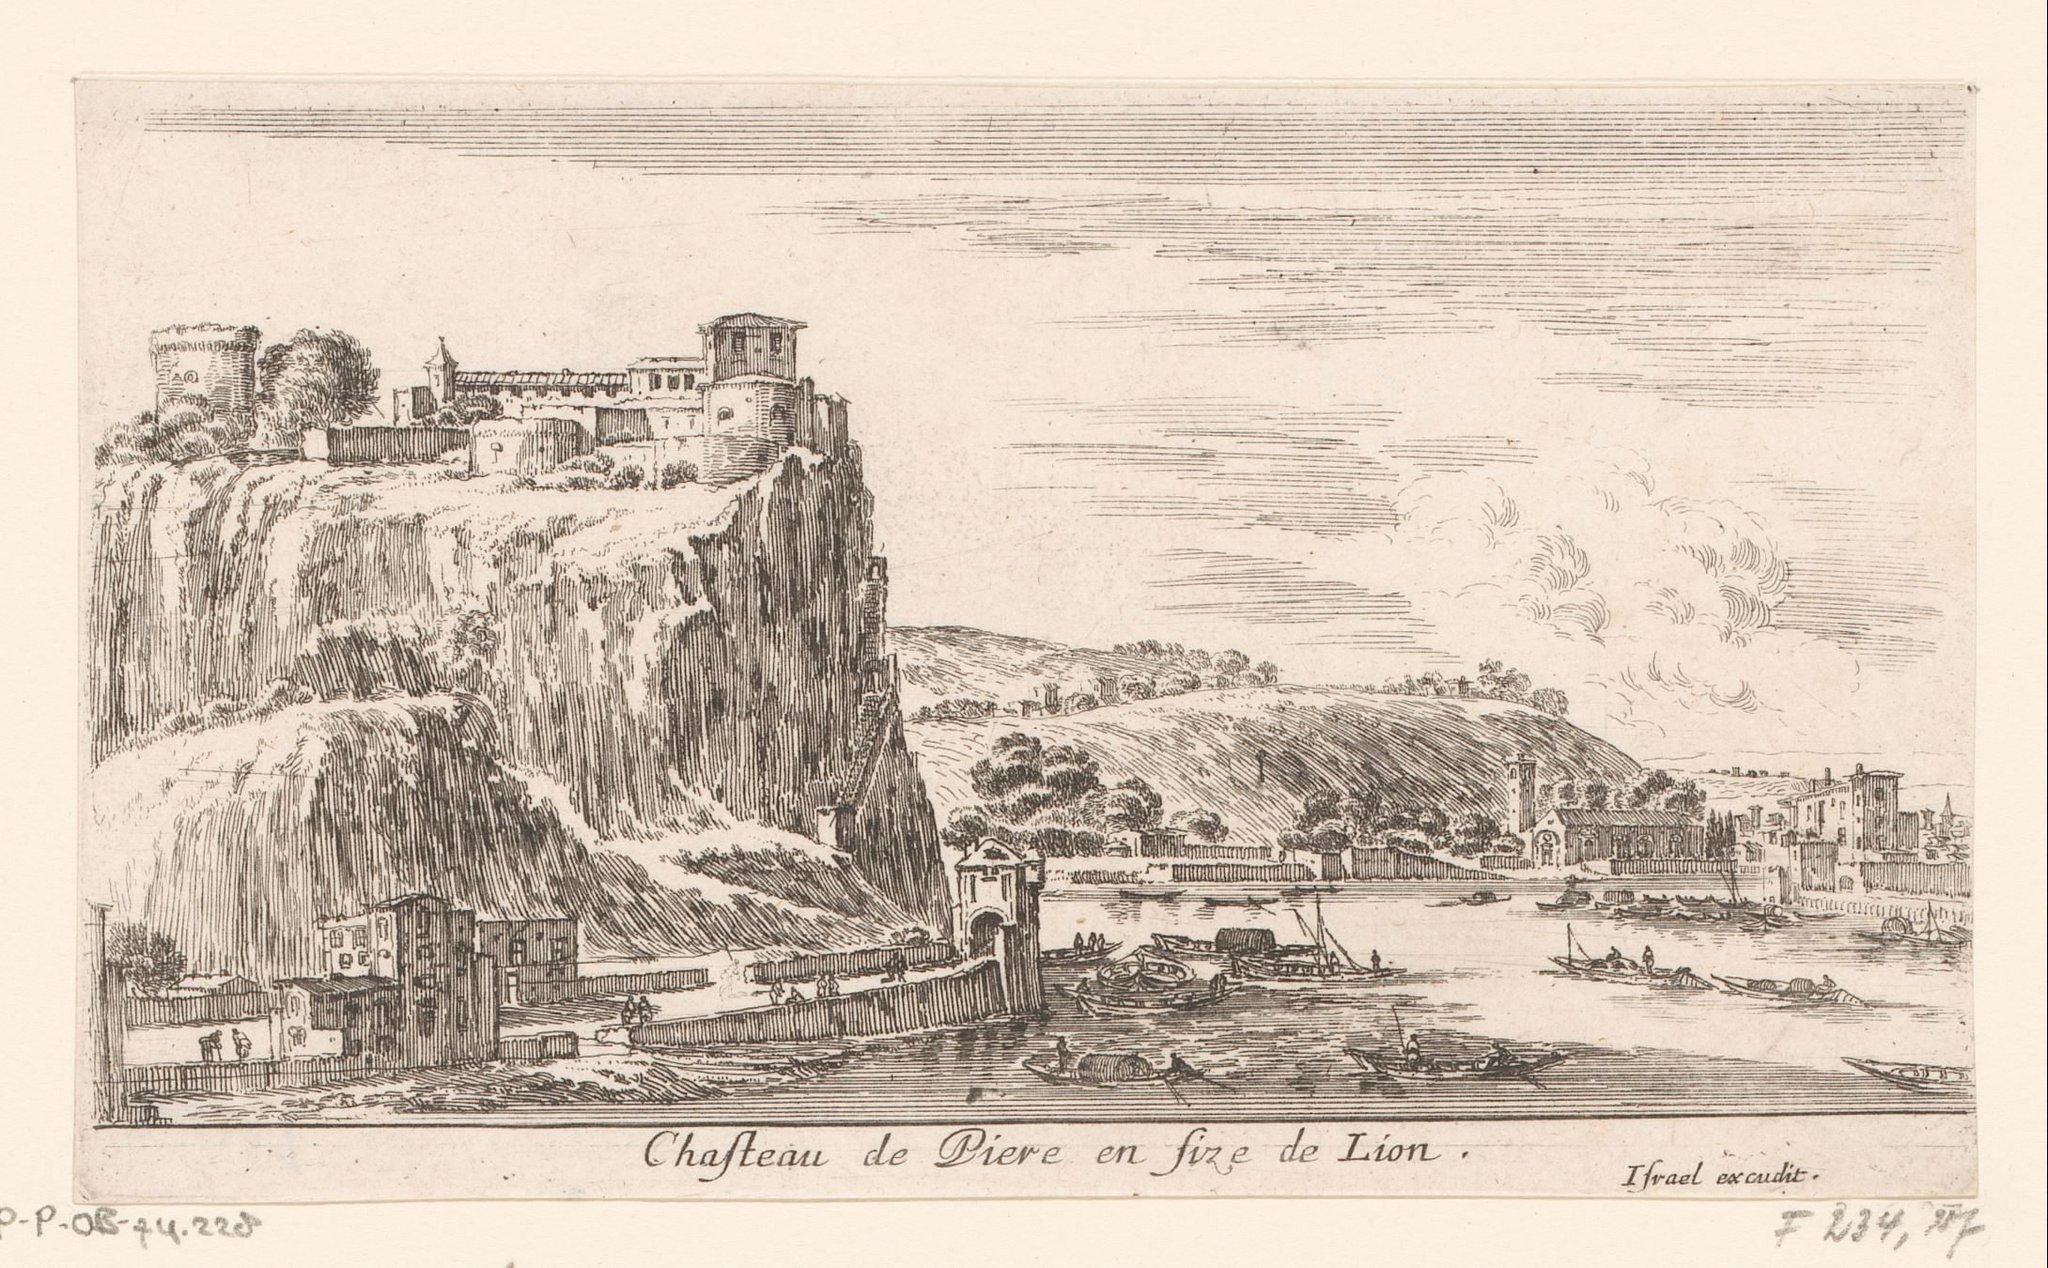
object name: print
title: Gezicht op kasteel Pierre Scize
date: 1631-1691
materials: paper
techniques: engraving, etching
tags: landscape with tower or castle, lyon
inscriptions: collector's mark: Lugt 240